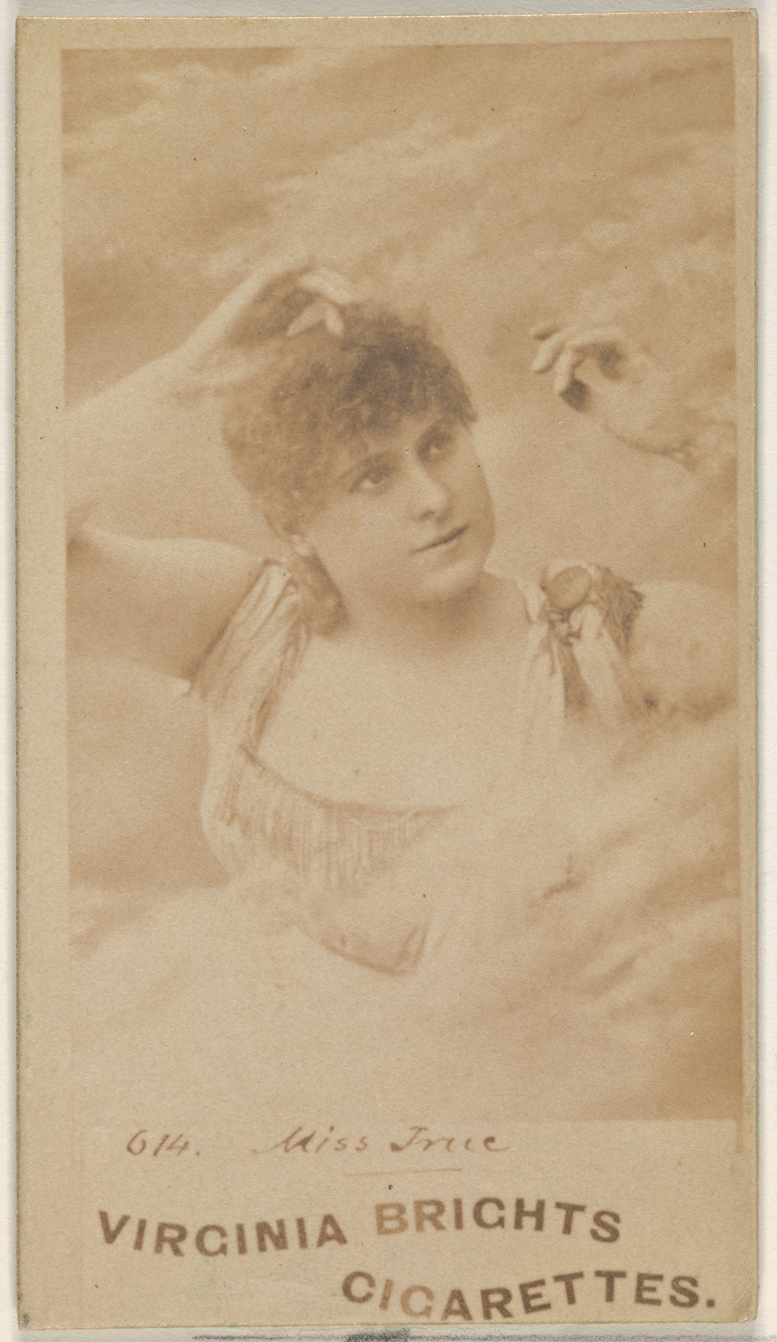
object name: photograph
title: Card 614, from the Actors and Actresses series (N45, Type 1) for Virginia Brights Cigarettes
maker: allen & ginter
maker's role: publisher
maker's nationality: american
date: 1888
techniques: albumen silver print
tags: portraits,women,actresses